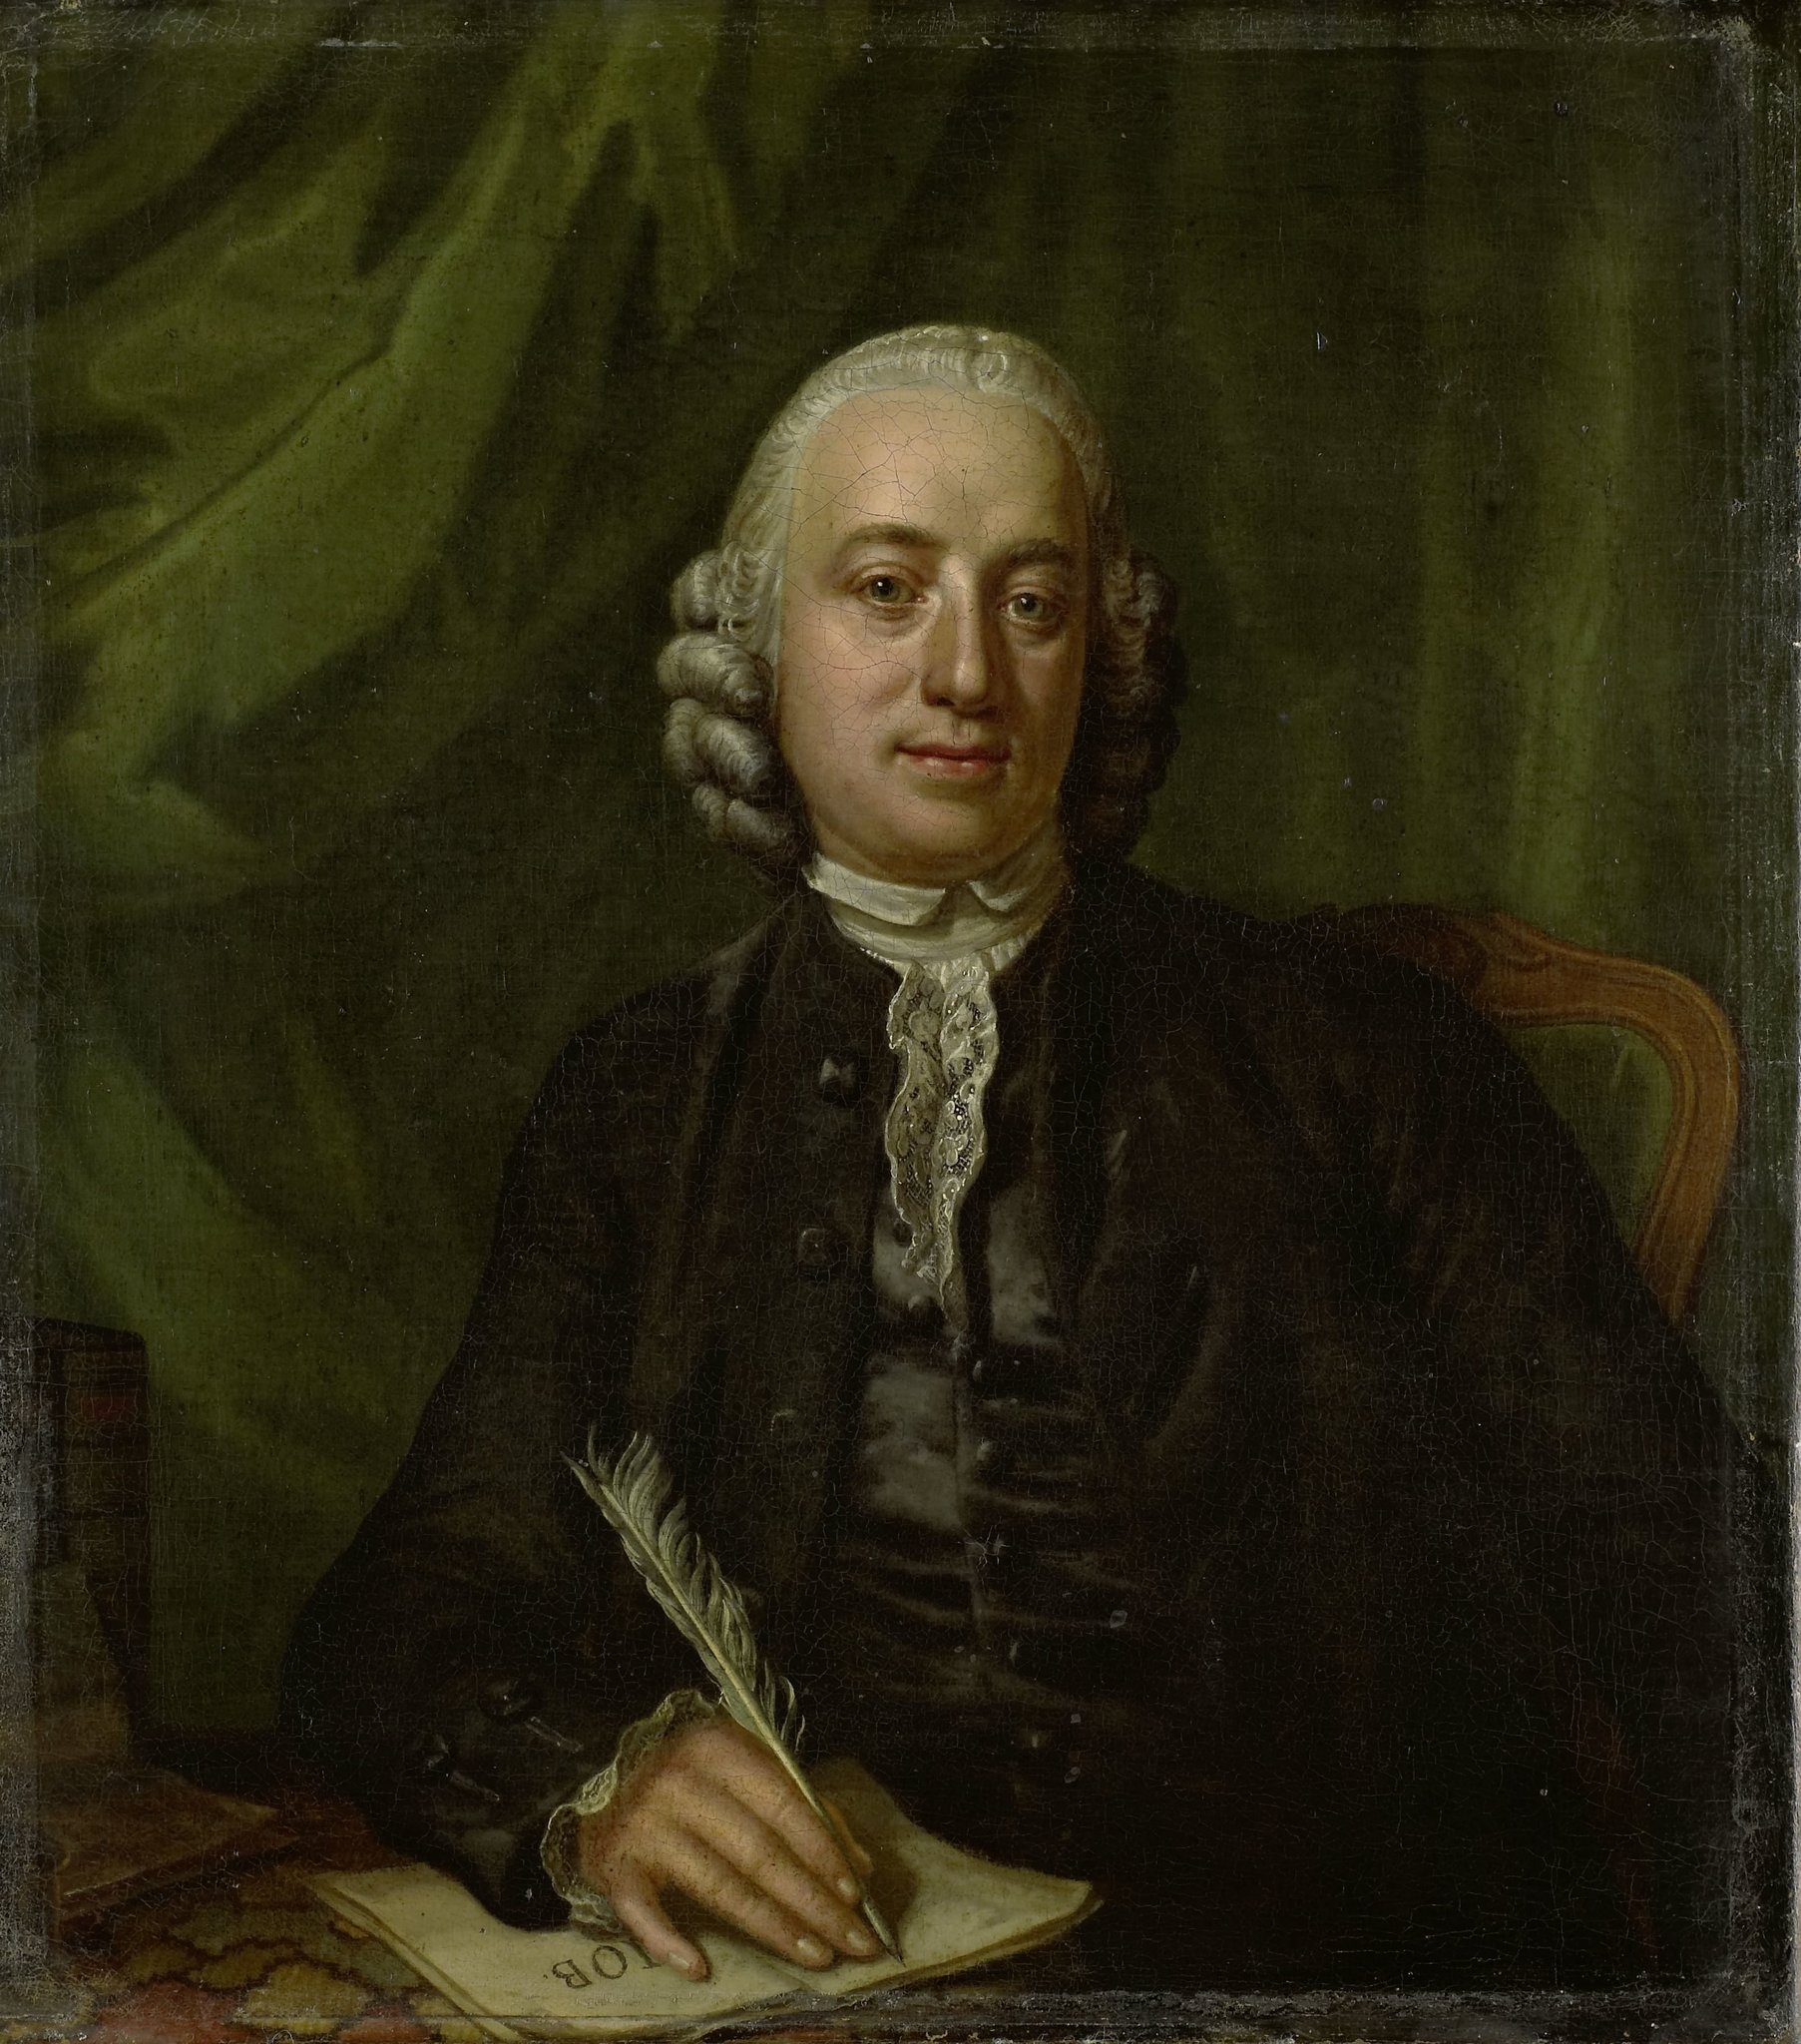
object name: painting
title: Portrait of Pieter Meijer, Publisher and Bookseller in Amsterdam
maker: hendrik pothoven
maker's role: draughtsman, painter, print maker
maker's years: 1725-1807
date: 1750-1781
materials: canvas, oil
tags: pieter meyer, historical persons, publishing, publisher, amsterdam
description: Pieter Meijer, attributed to Hendrik Pothoven (1736-1807). Pieter Meijer (1718-1781) was one of the founders in 1767 of a society to promote and develop new lifesaving techniques - the Maatschappij tot Redding van Drenkelingen. Meijer was a poet who ran a bookshop and publishing company in Amsterdam, selling the publications of various societies.